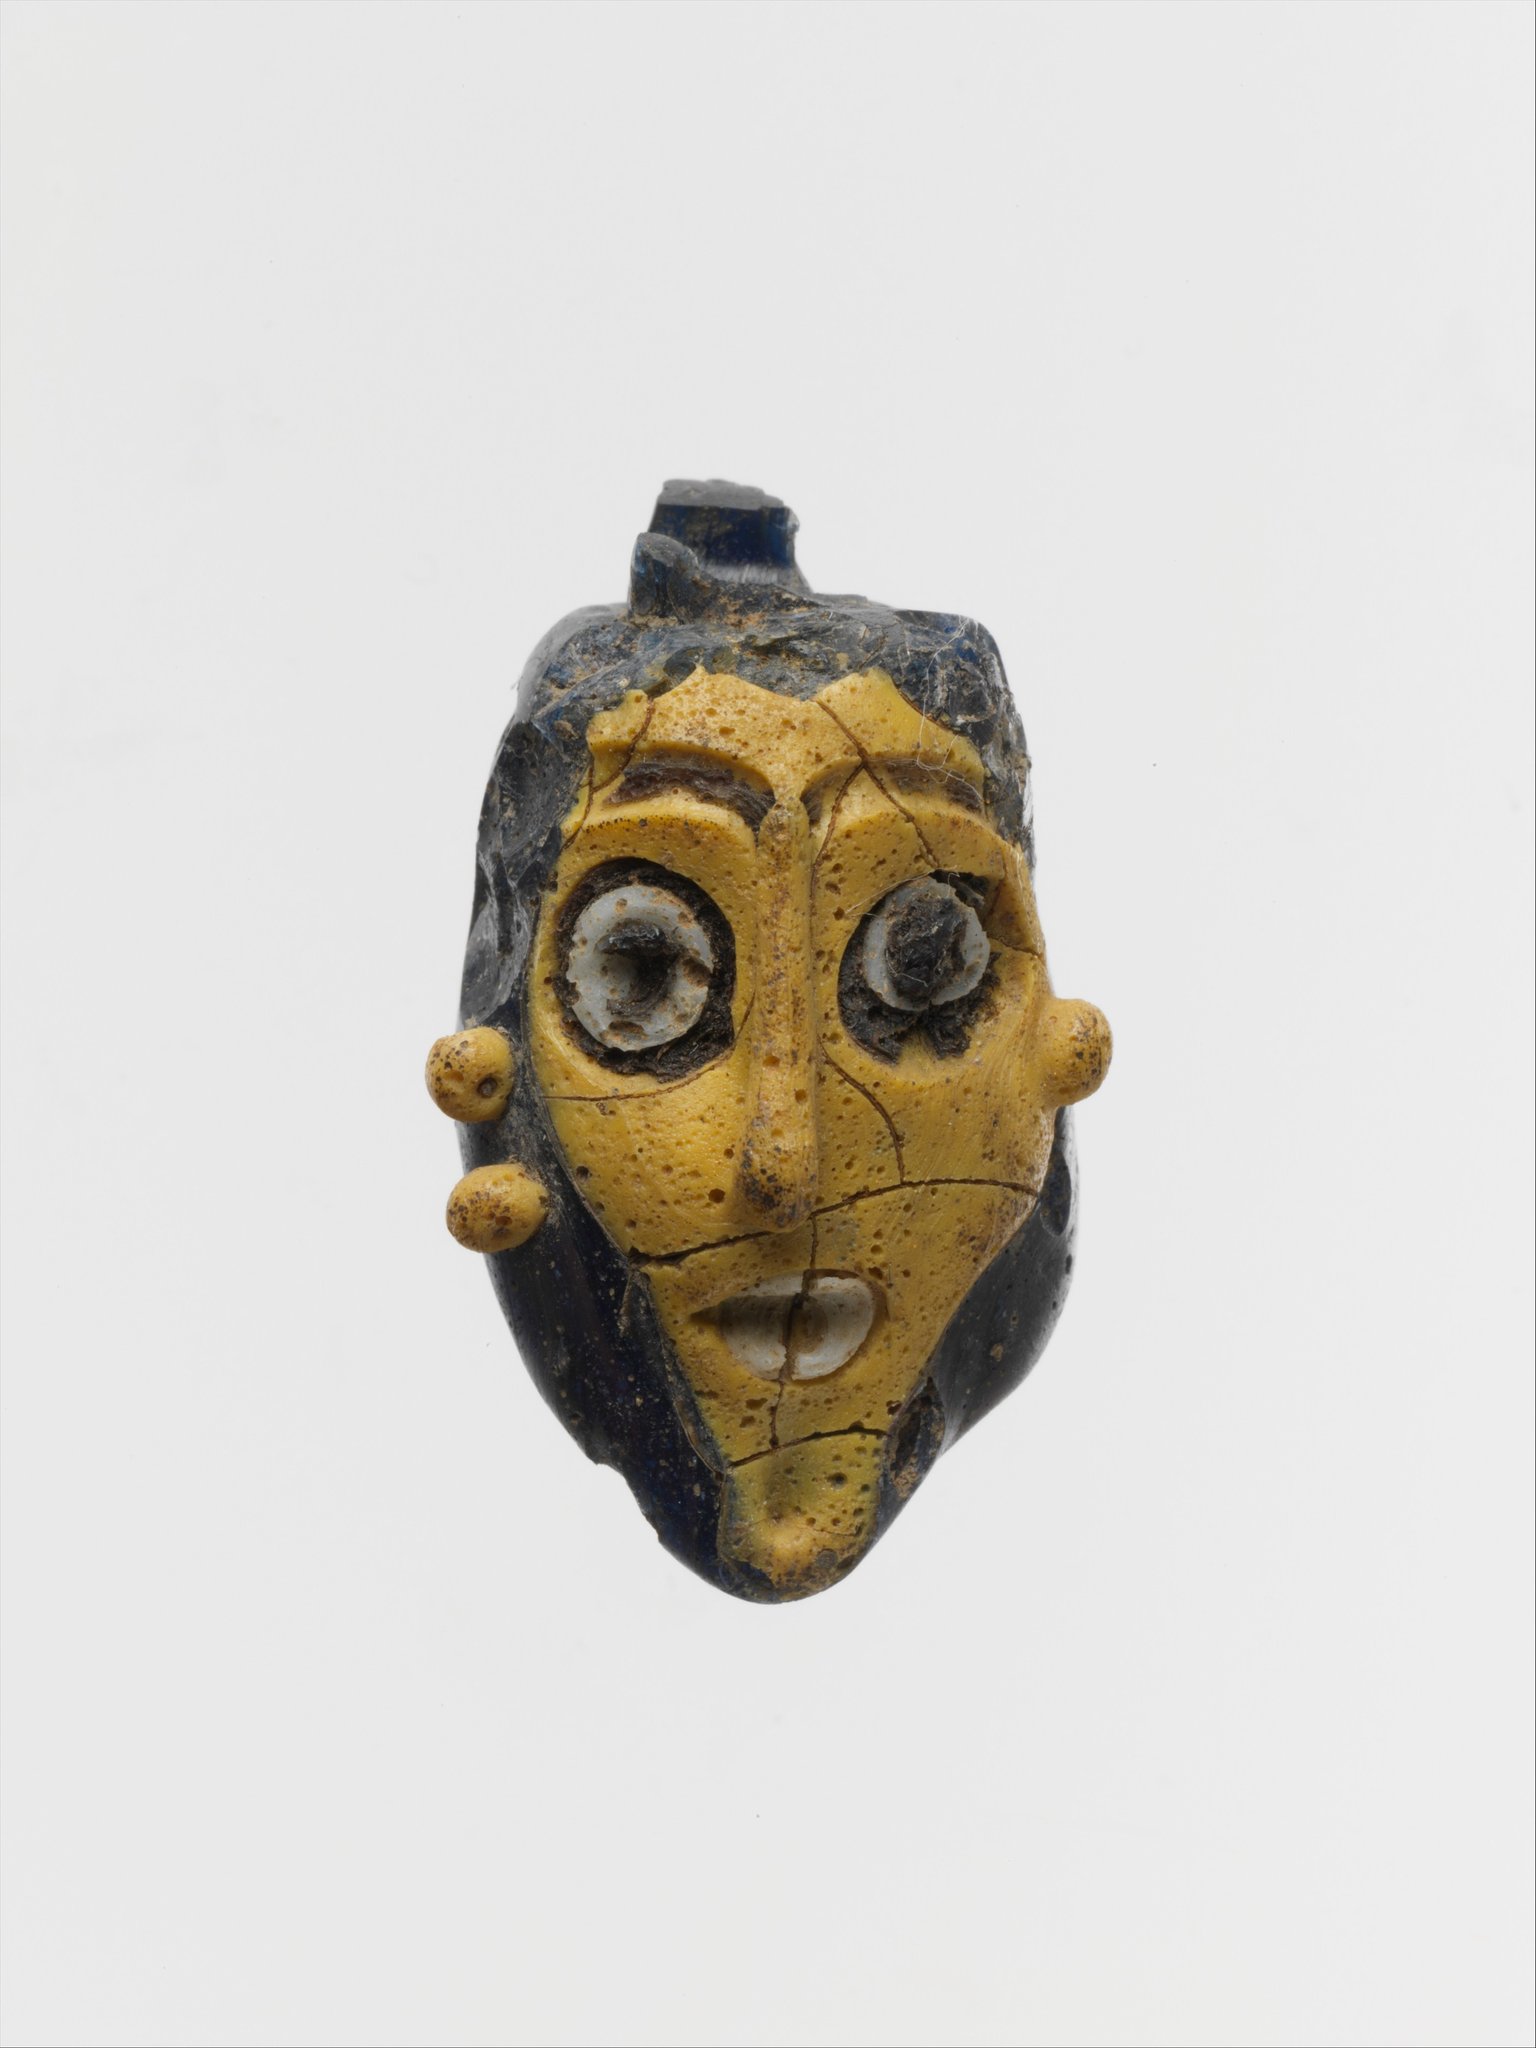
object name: head pendant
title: Glass head pendant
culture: phoenician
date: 650-550 BCE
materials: glass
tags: heads